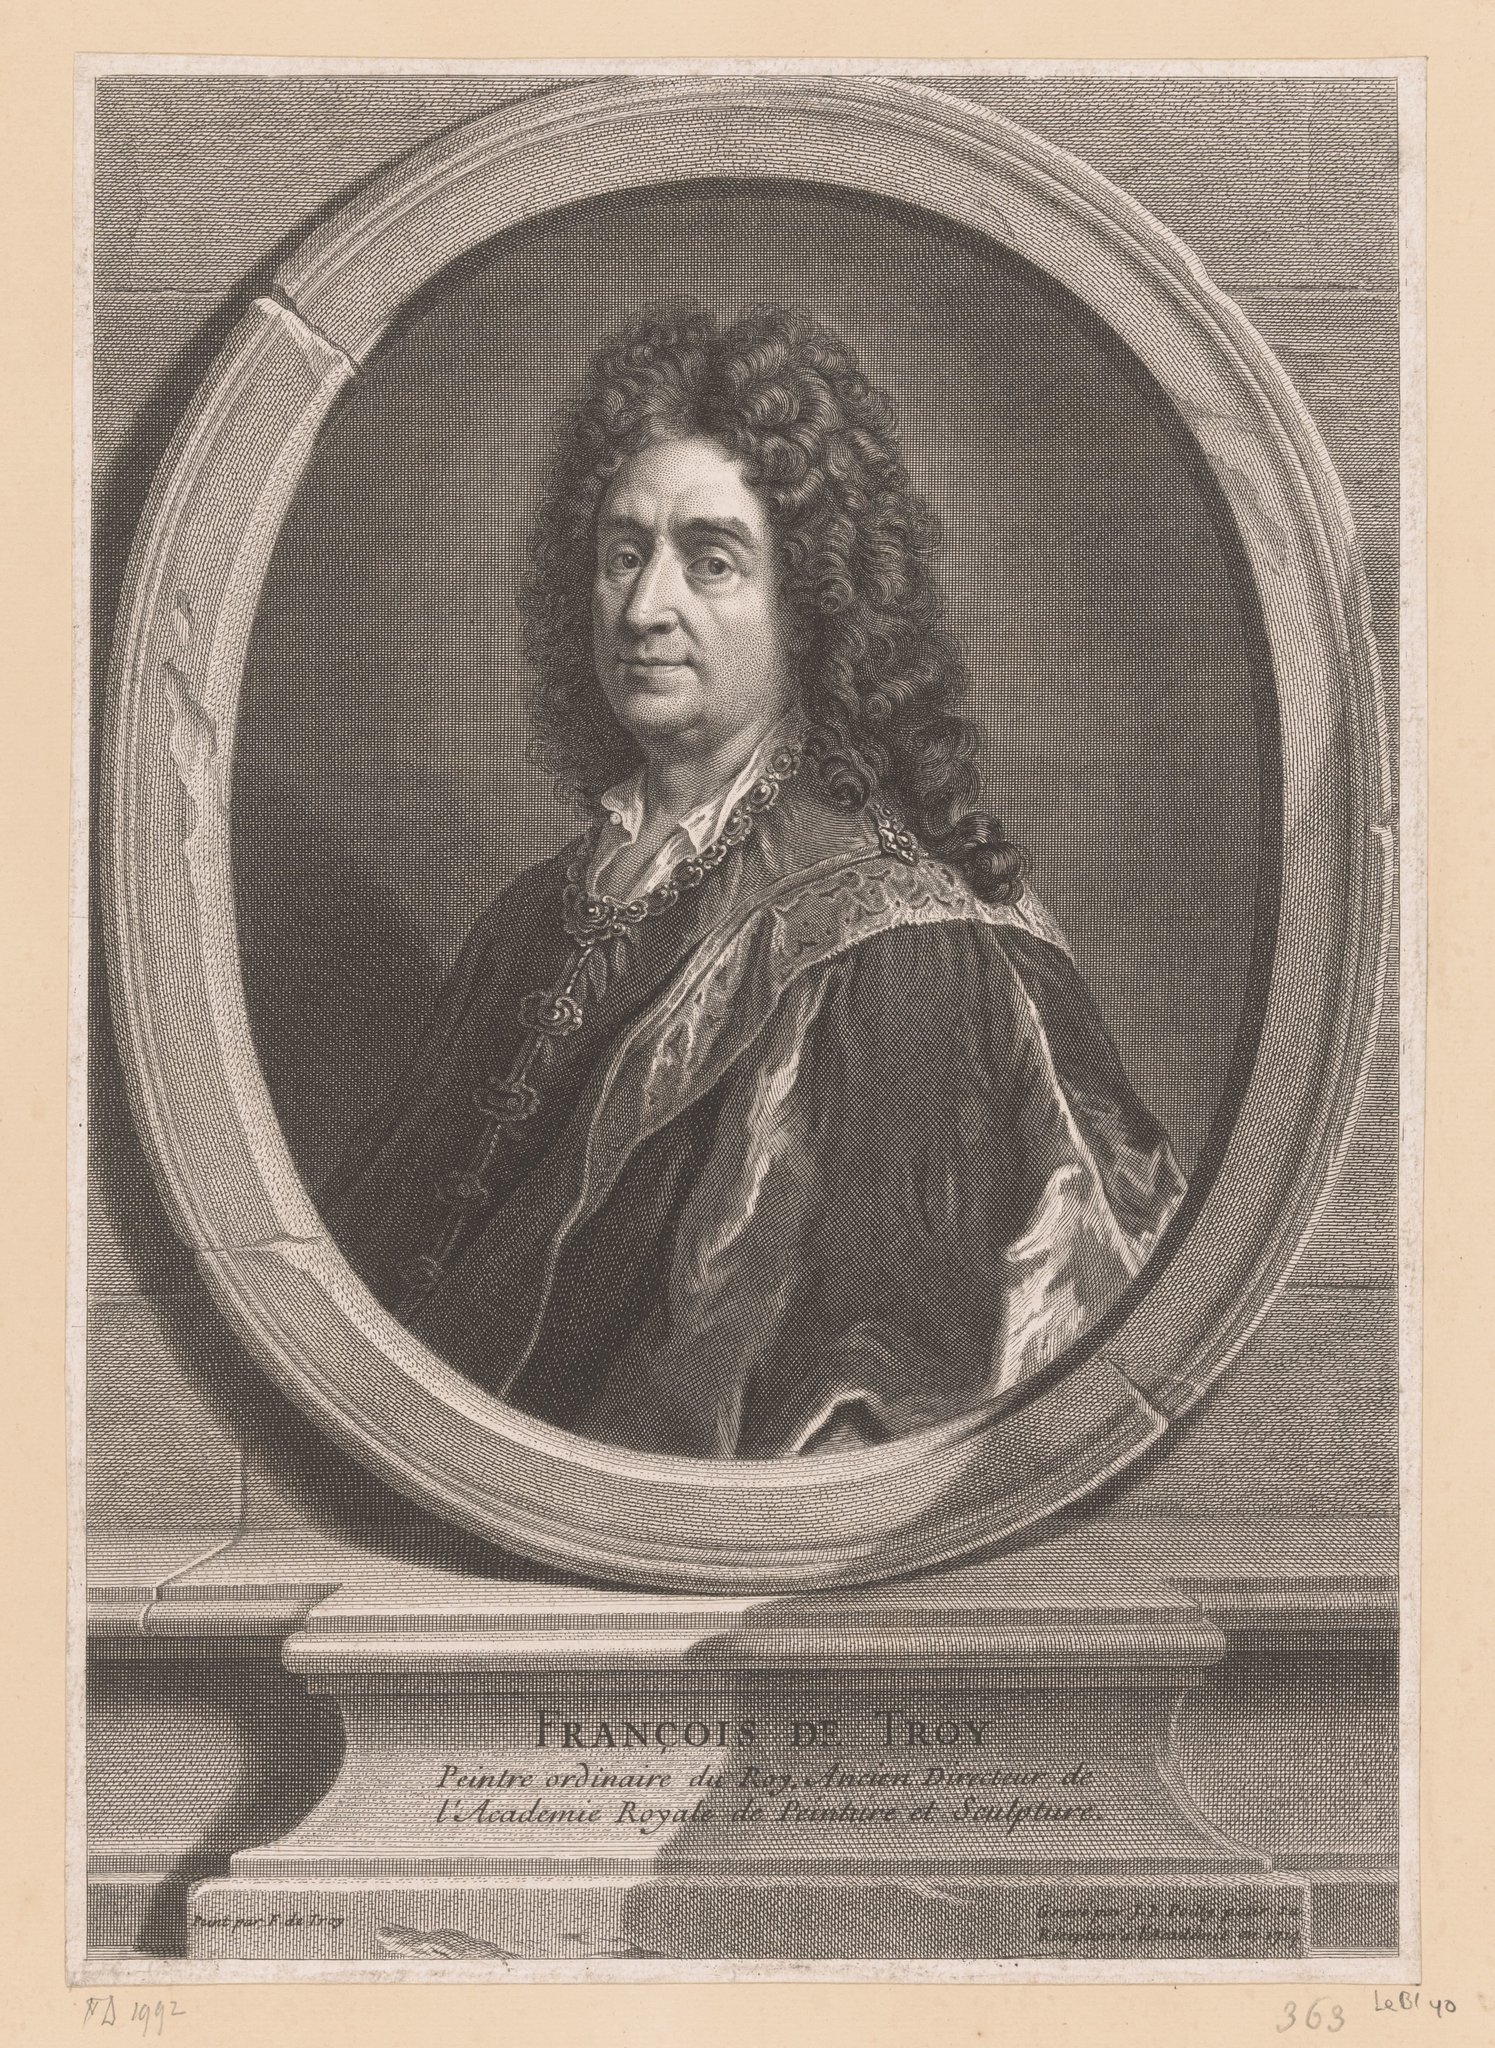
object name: print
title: Portret van François de Troy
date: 1714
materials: paper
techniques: engraving, etching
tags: paris, painter, françois de troy, historical persons, portrait, self-portrait of painter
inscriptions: collector's mark: Lugt 240